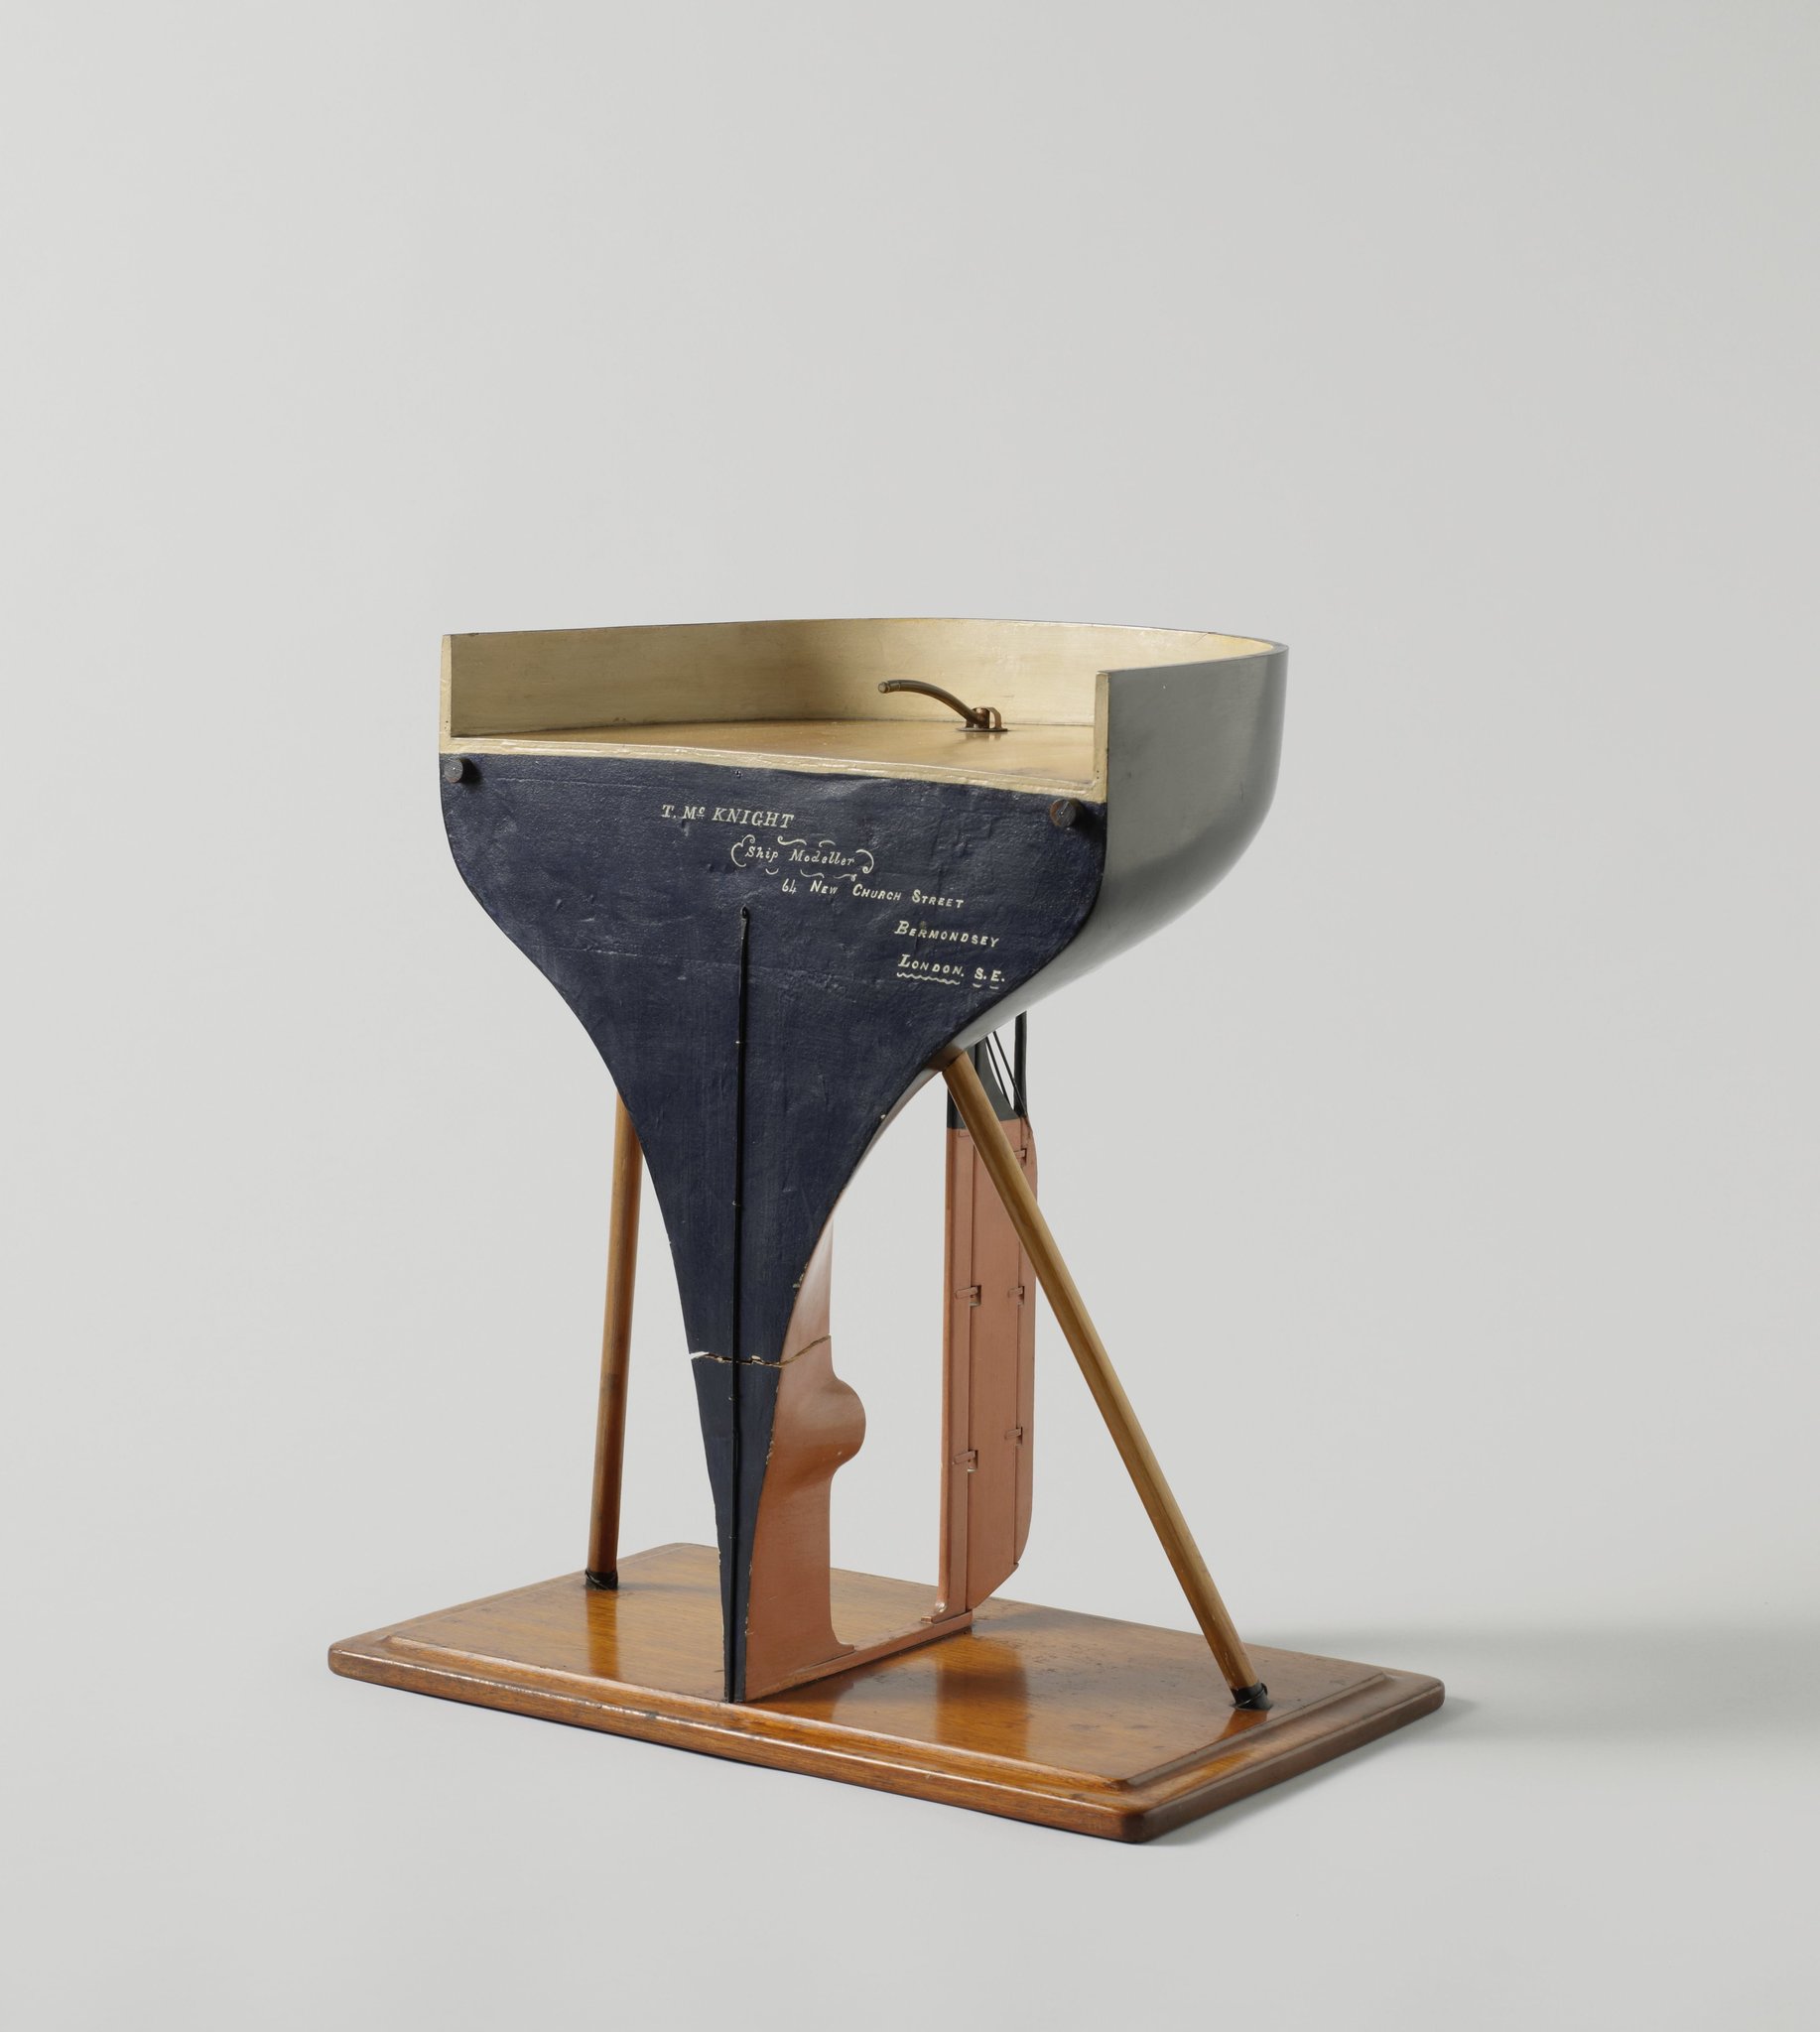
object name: presentation model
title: Model of a Stern with Lumley’s Patent Rudder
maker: t. mcknight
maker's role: model maker, ship modeller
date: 1865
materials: copper, iron, wood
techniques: polychromy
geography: london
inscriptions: inscription, on the stern: ‘LUMLEY’s PATENT RUDDER’, inscription, on the inside of the hull: ‘T. Mc KNIGHT / Ship Modeller / 66. NEW CHURCH STREET / BERMONDSEY / LONDON. S.E.’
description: Zwart en roze model van een elliptisch hek met schroefraam, met twee steunen op een grondplank. De roersteven heeft een hiel en drie roerstellen, de roerkoning is rond en loopt tot op het dek, waar een korte roerpen zit. Het roerblad is verticaal in twee stukken opgedeeld, het achterste deel met drie roerstellen aan het voorste bevestigd. Het achterblad heeft een eigen roerkoning, die aan een schuifmechanisme, dat met drie poten tegen het wulf is bevestigd, vastzit: bij draaiing van het roer slaat het achterblad door dit mechanisme extra ver uit.